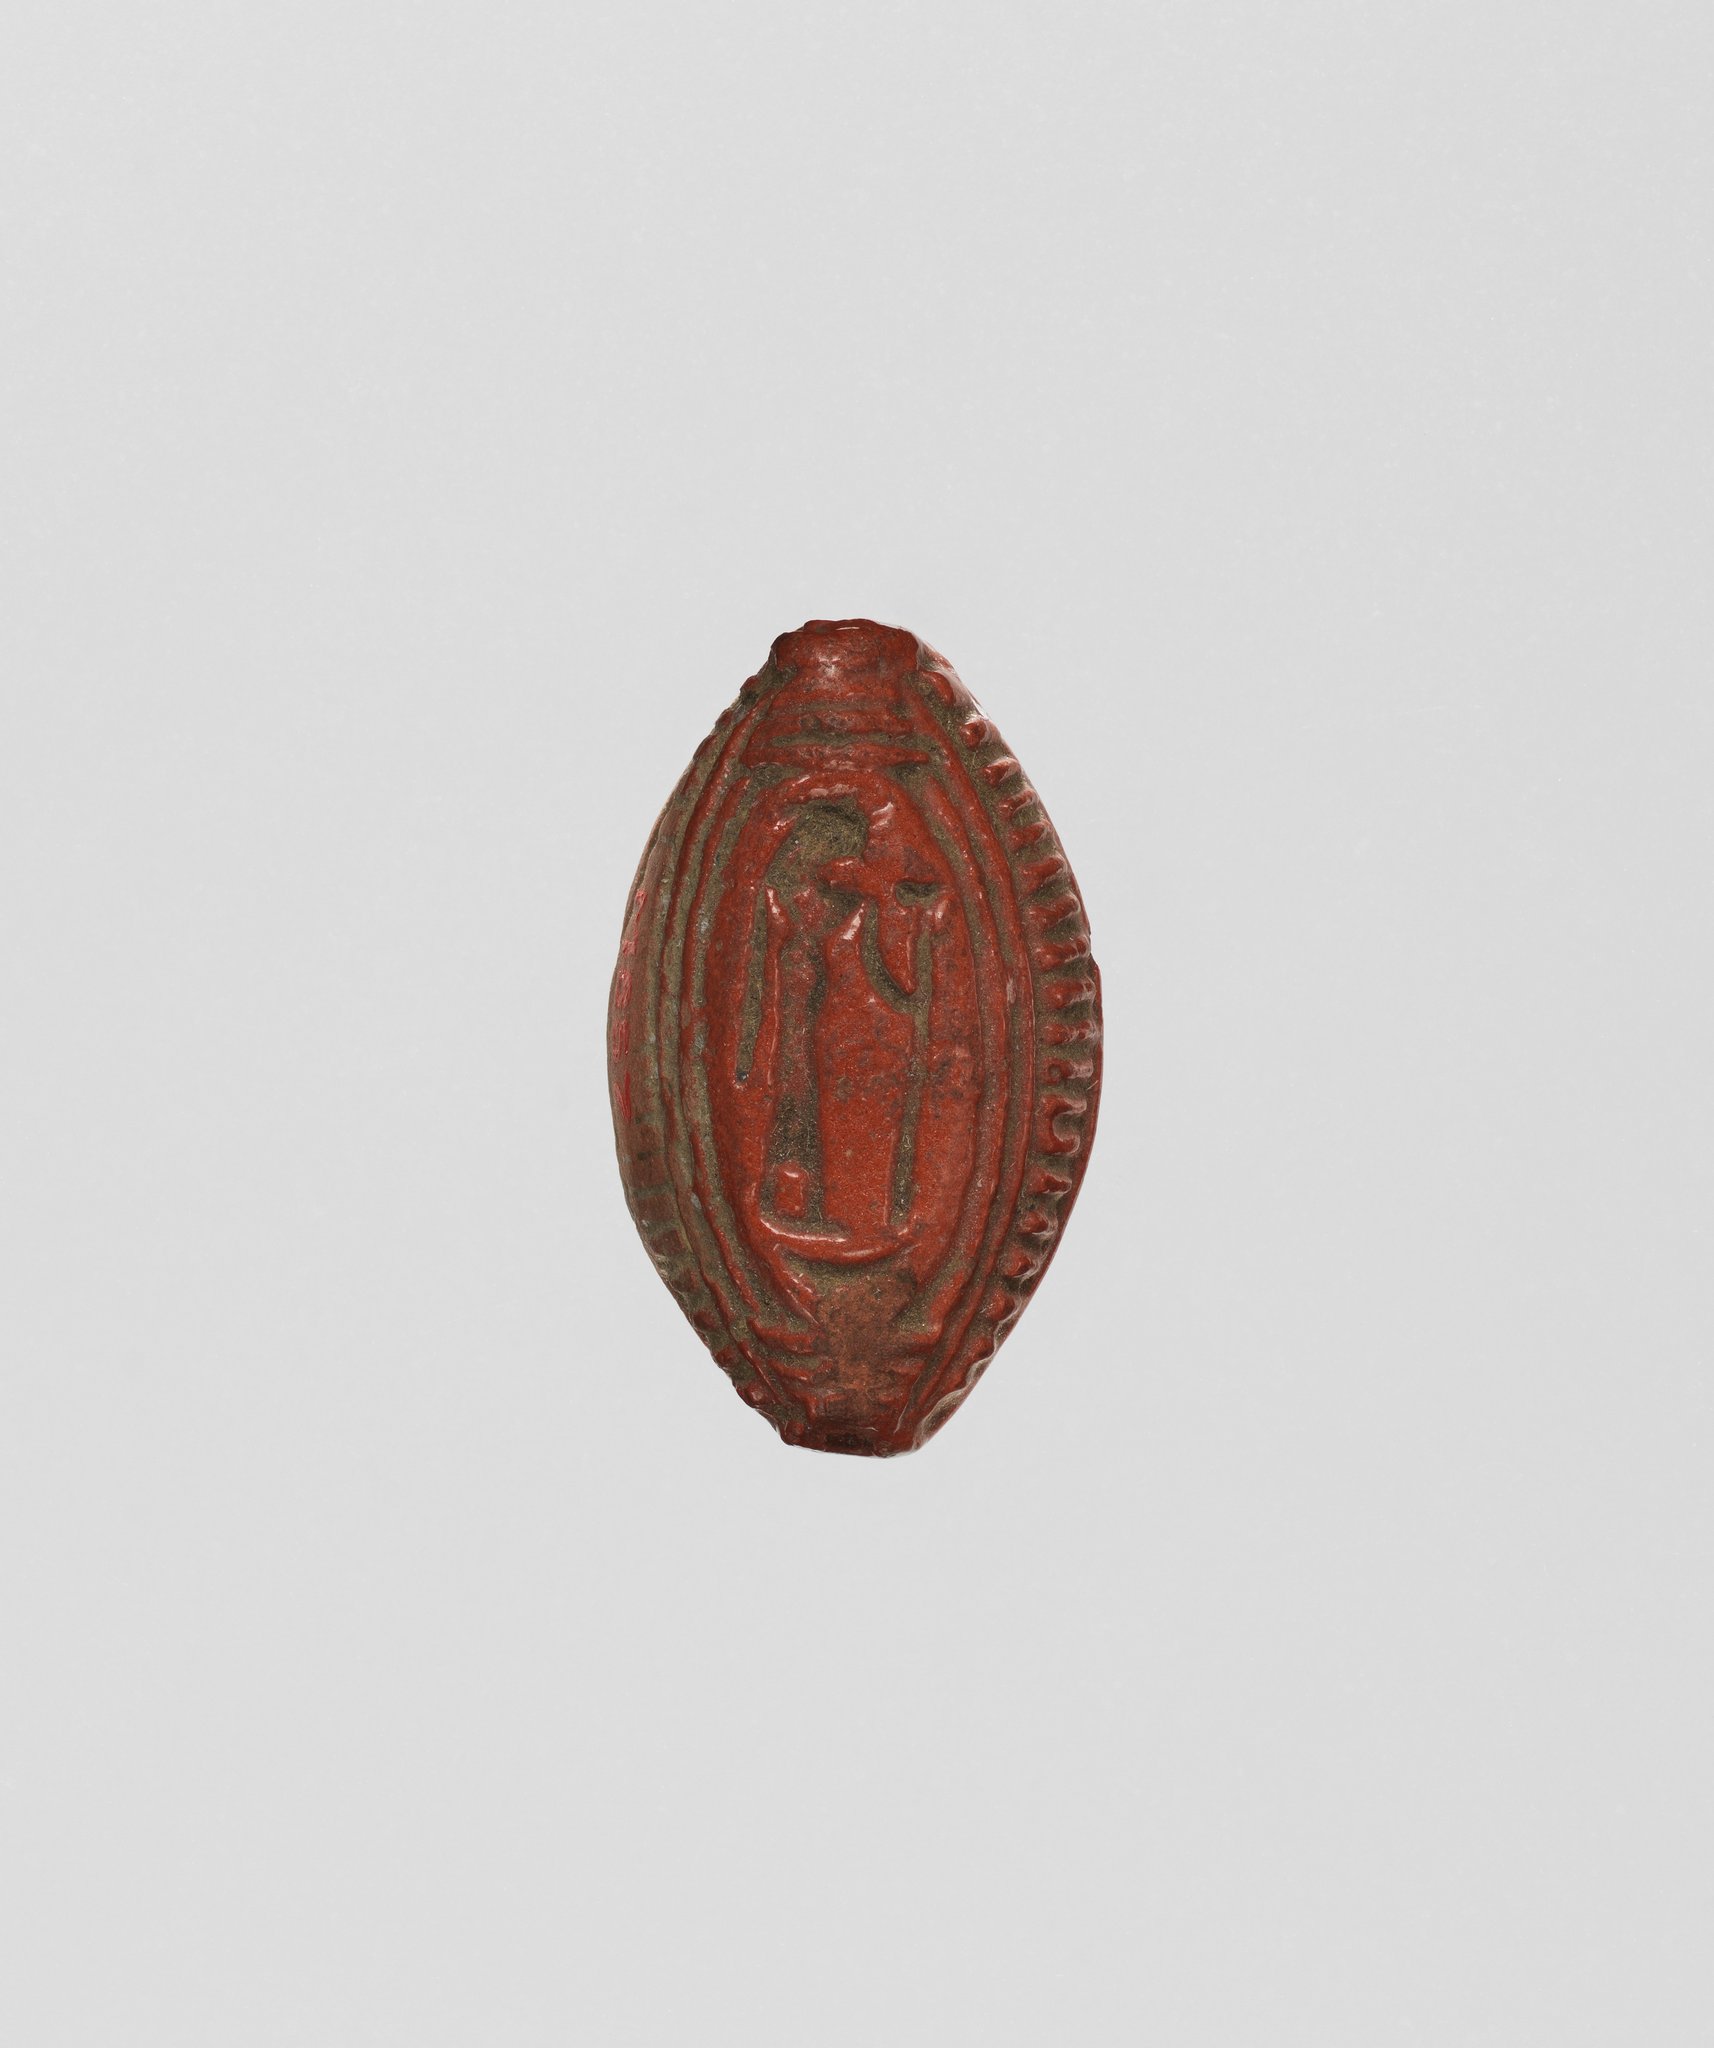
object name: cowroid, goddess, wa scepter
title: Cowroid with a standing female figure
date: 1200-525 BCE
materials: faience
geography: egypt